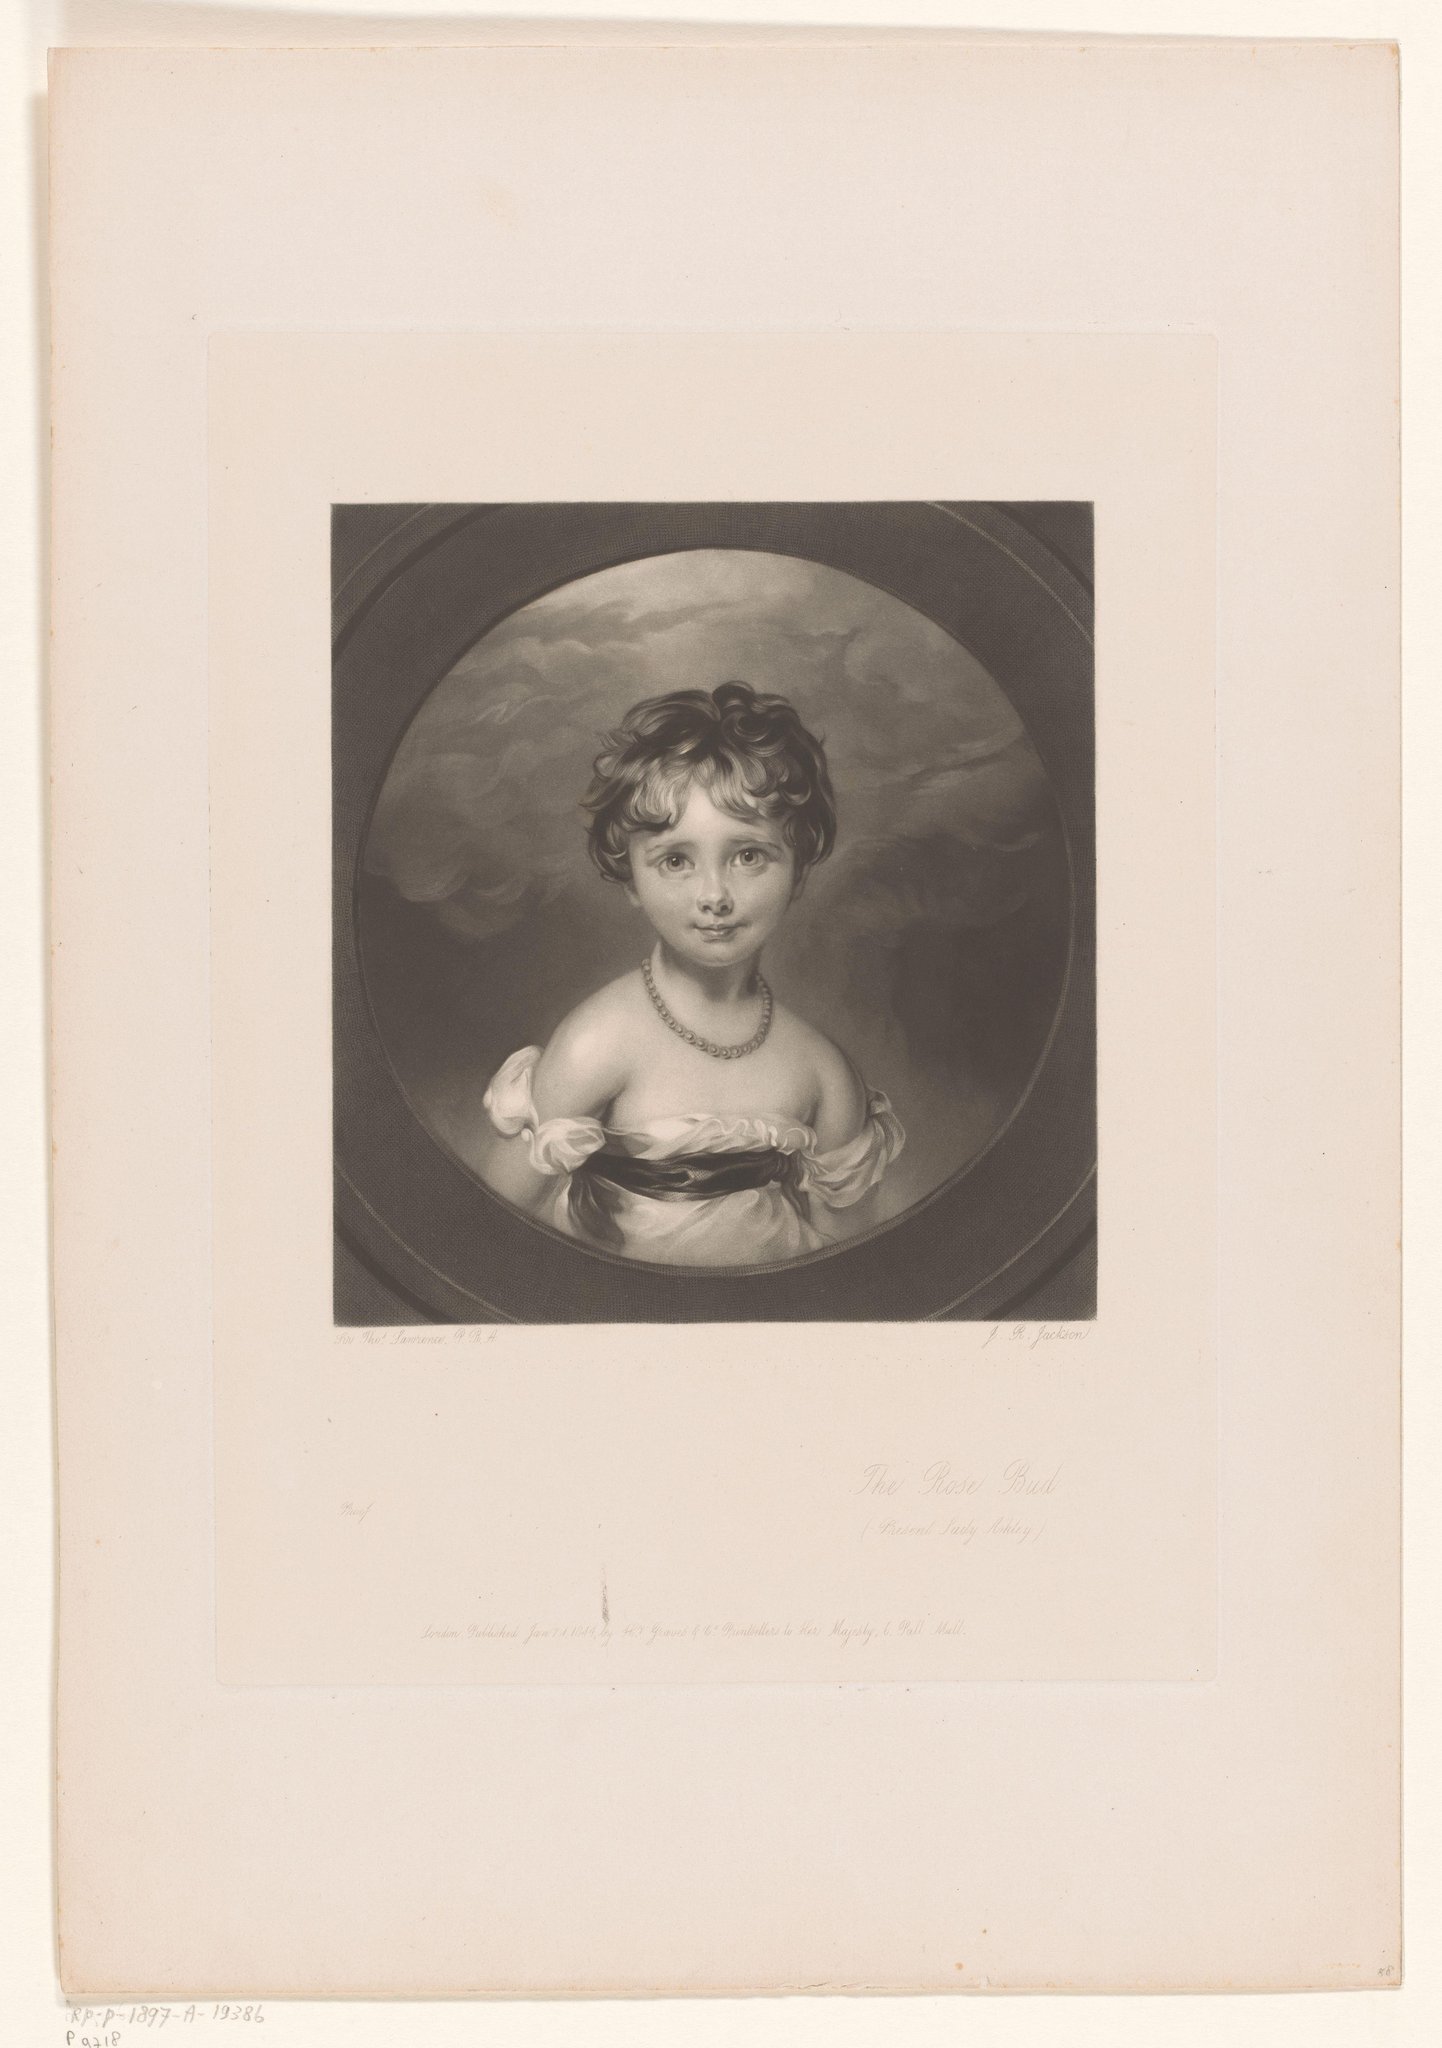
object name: print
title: The Rose Bud / (Present Lady Ashley)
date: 1834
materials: paper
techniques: mezzotint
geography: london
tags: historical persons, girl (child between toddler and youth)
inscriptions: collector's mark: Lugt 2228